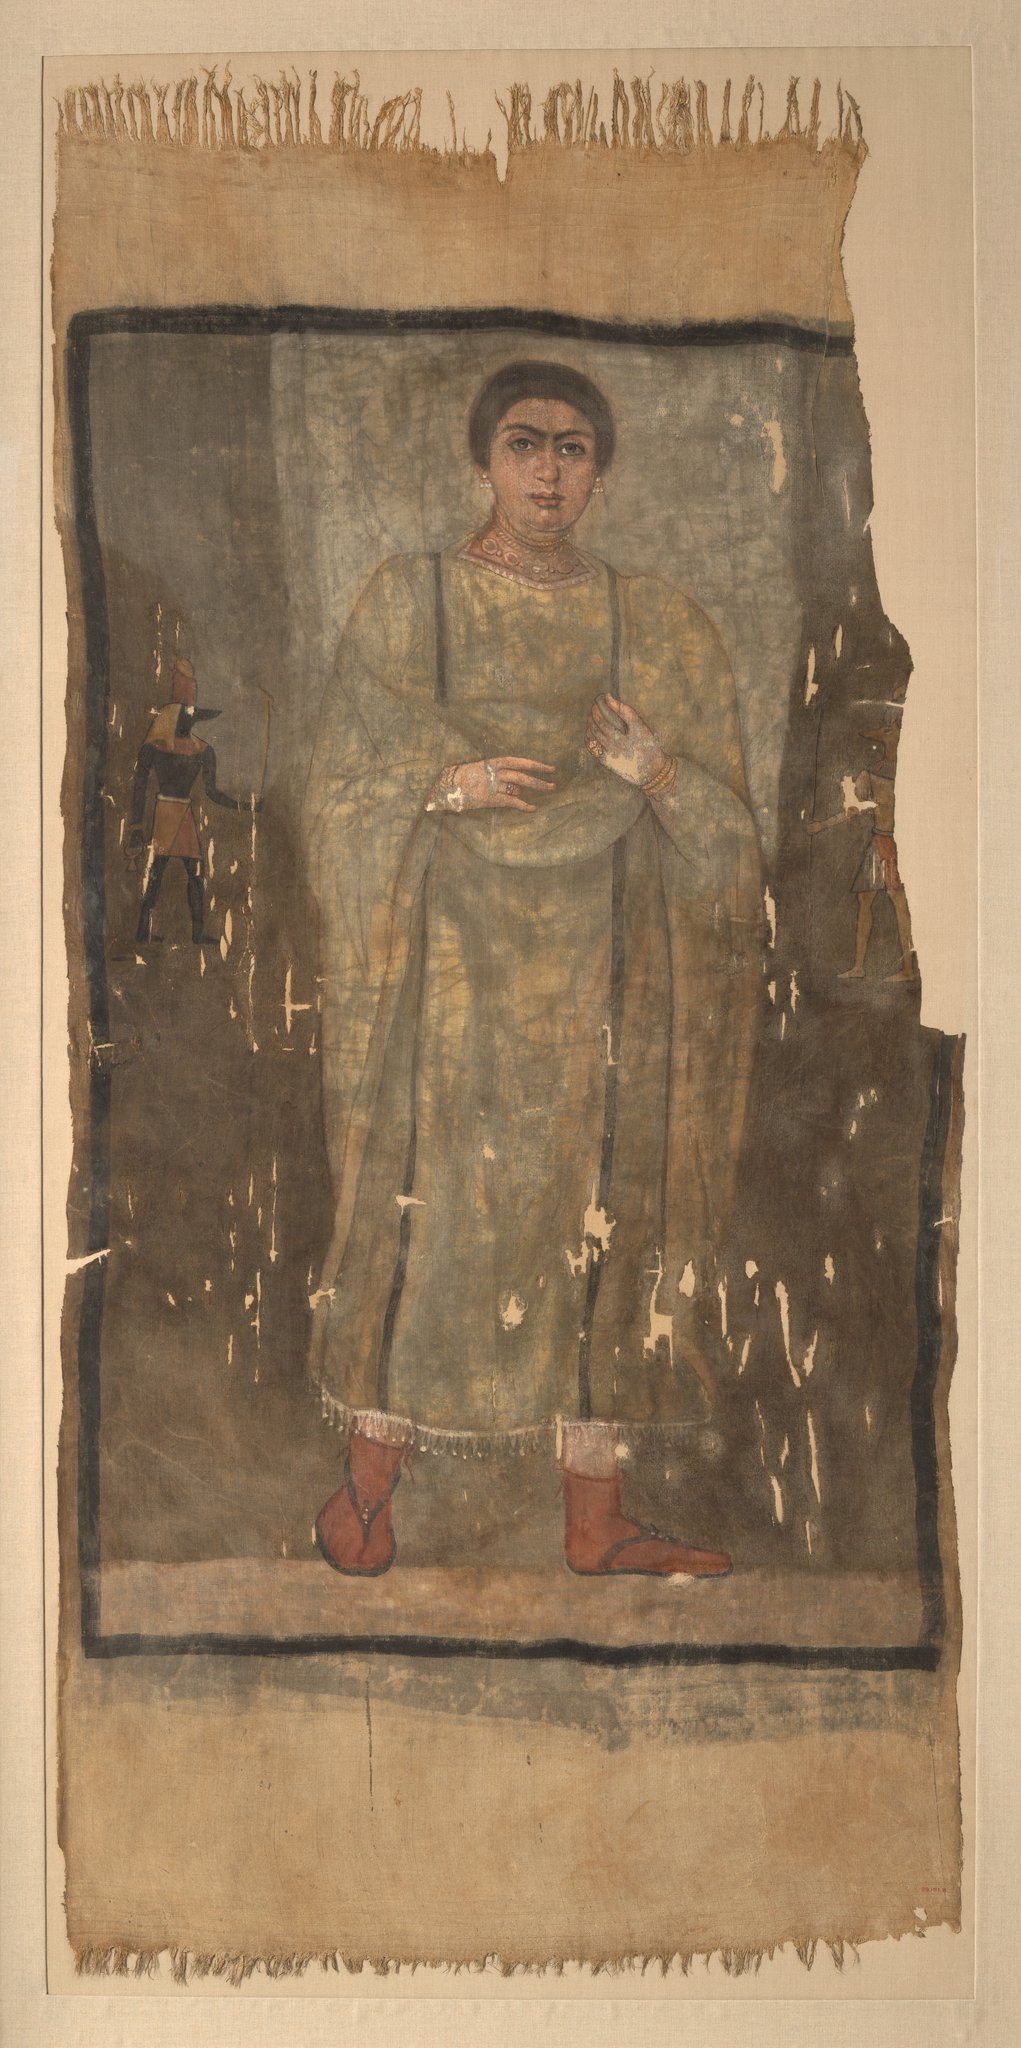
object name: shroud, woman, fringed tunic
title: Shroud of a Woman Wearing a Fringed Tunic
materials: linen, paint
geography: middle egypt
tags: portraits,women